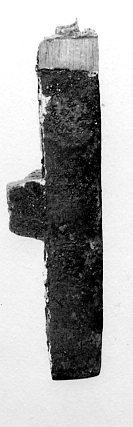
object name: model, bed, frame fragment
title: Frame Fragment from a Model Bed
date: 1550-1295 BCE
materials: wood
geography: egypt